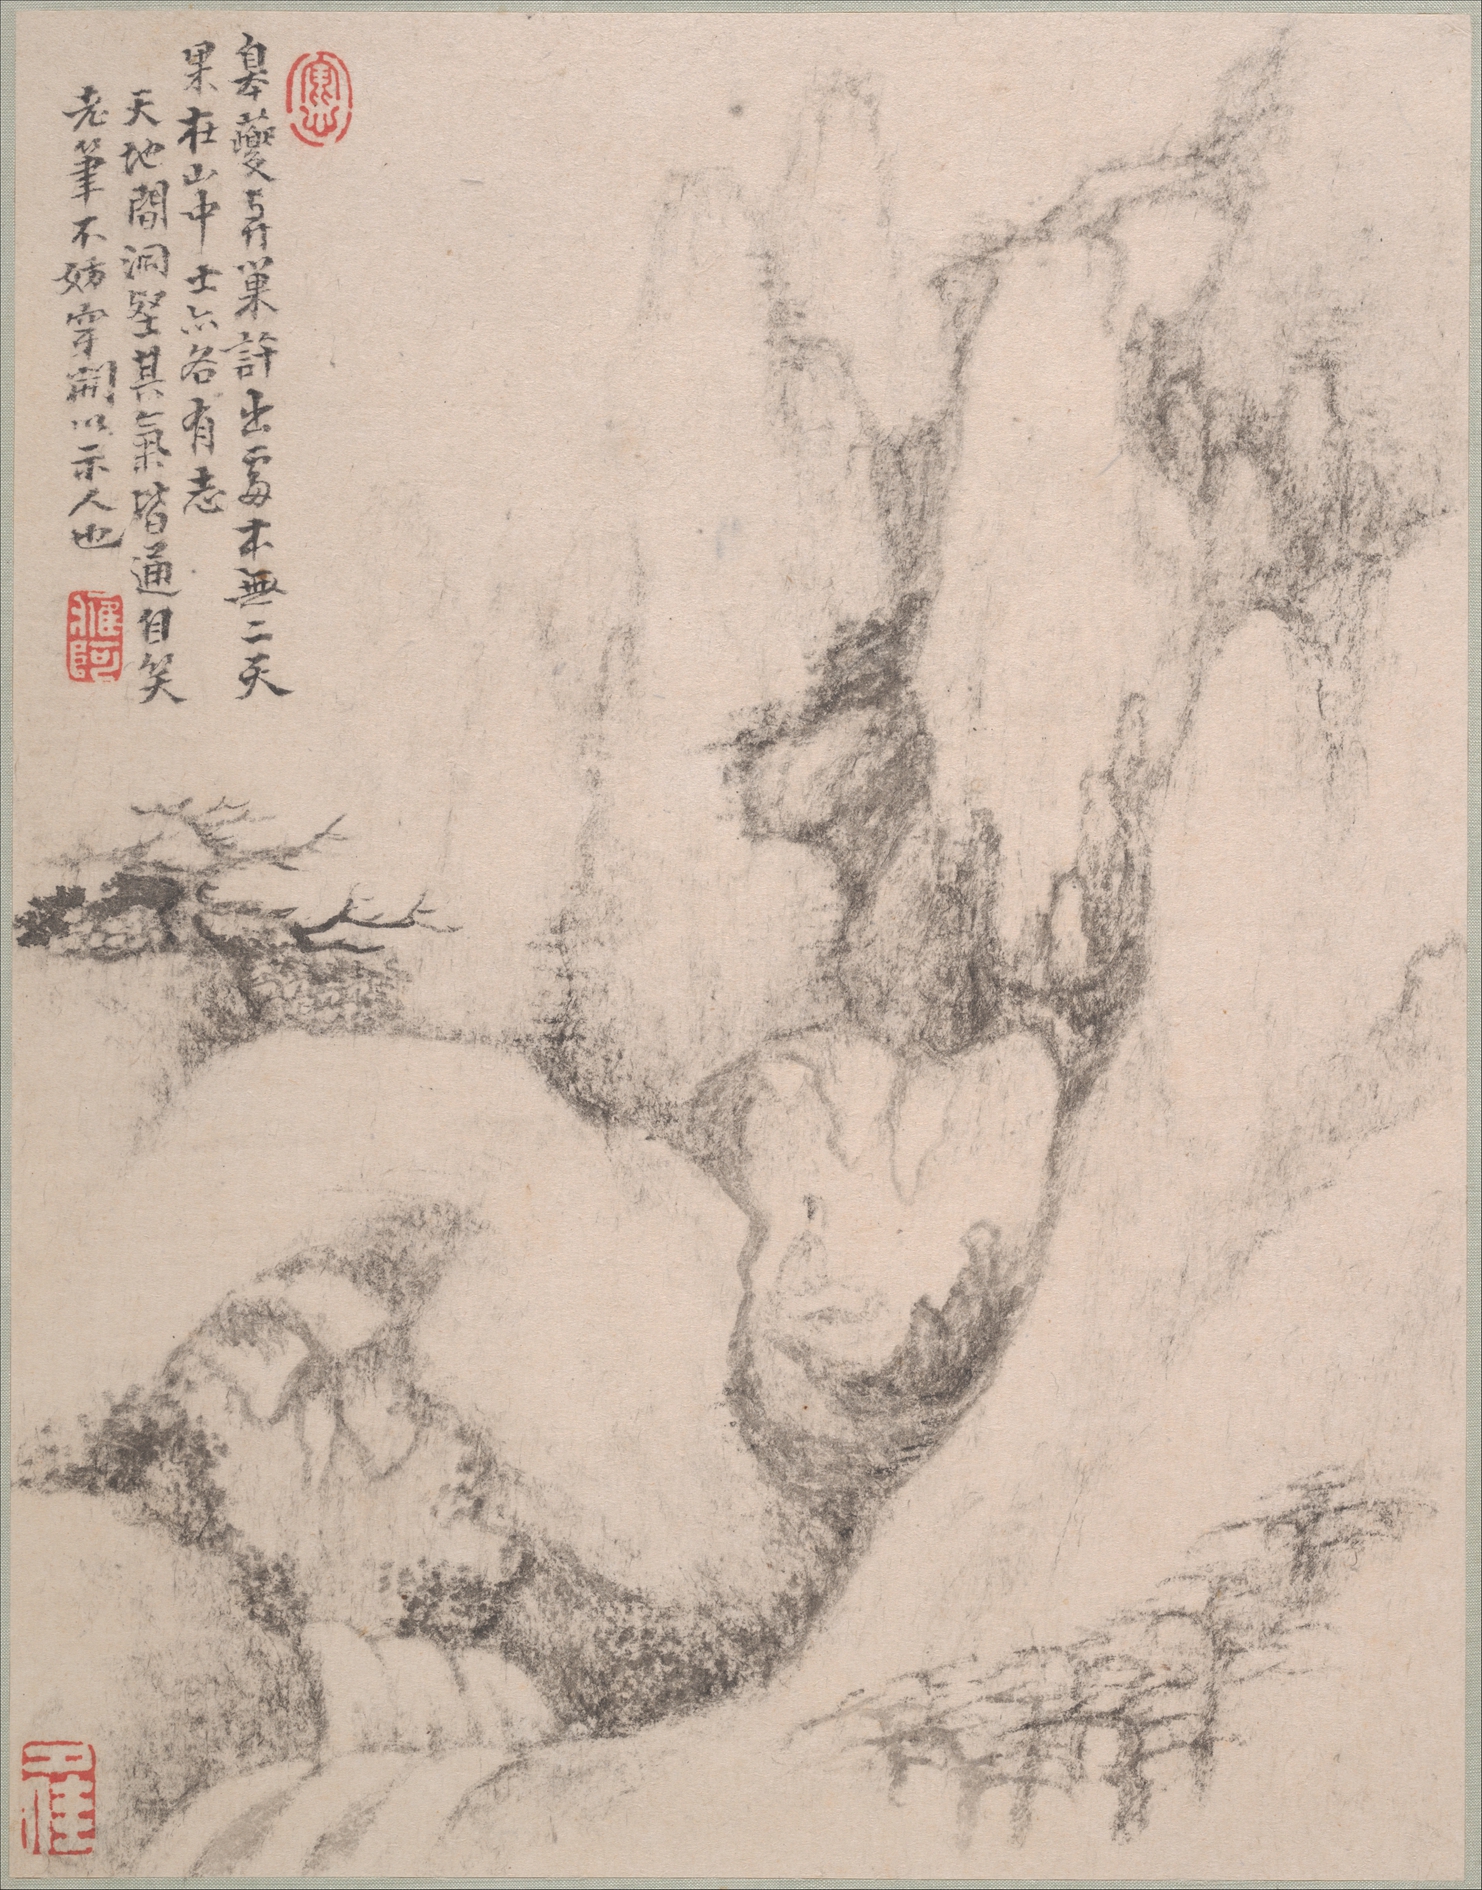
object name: album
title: Landscapes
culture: chinese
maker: dai benxiao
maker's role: artist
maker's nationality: chinese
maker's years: 1621-1693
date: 1667-1700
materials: ink, paper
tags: landscapes